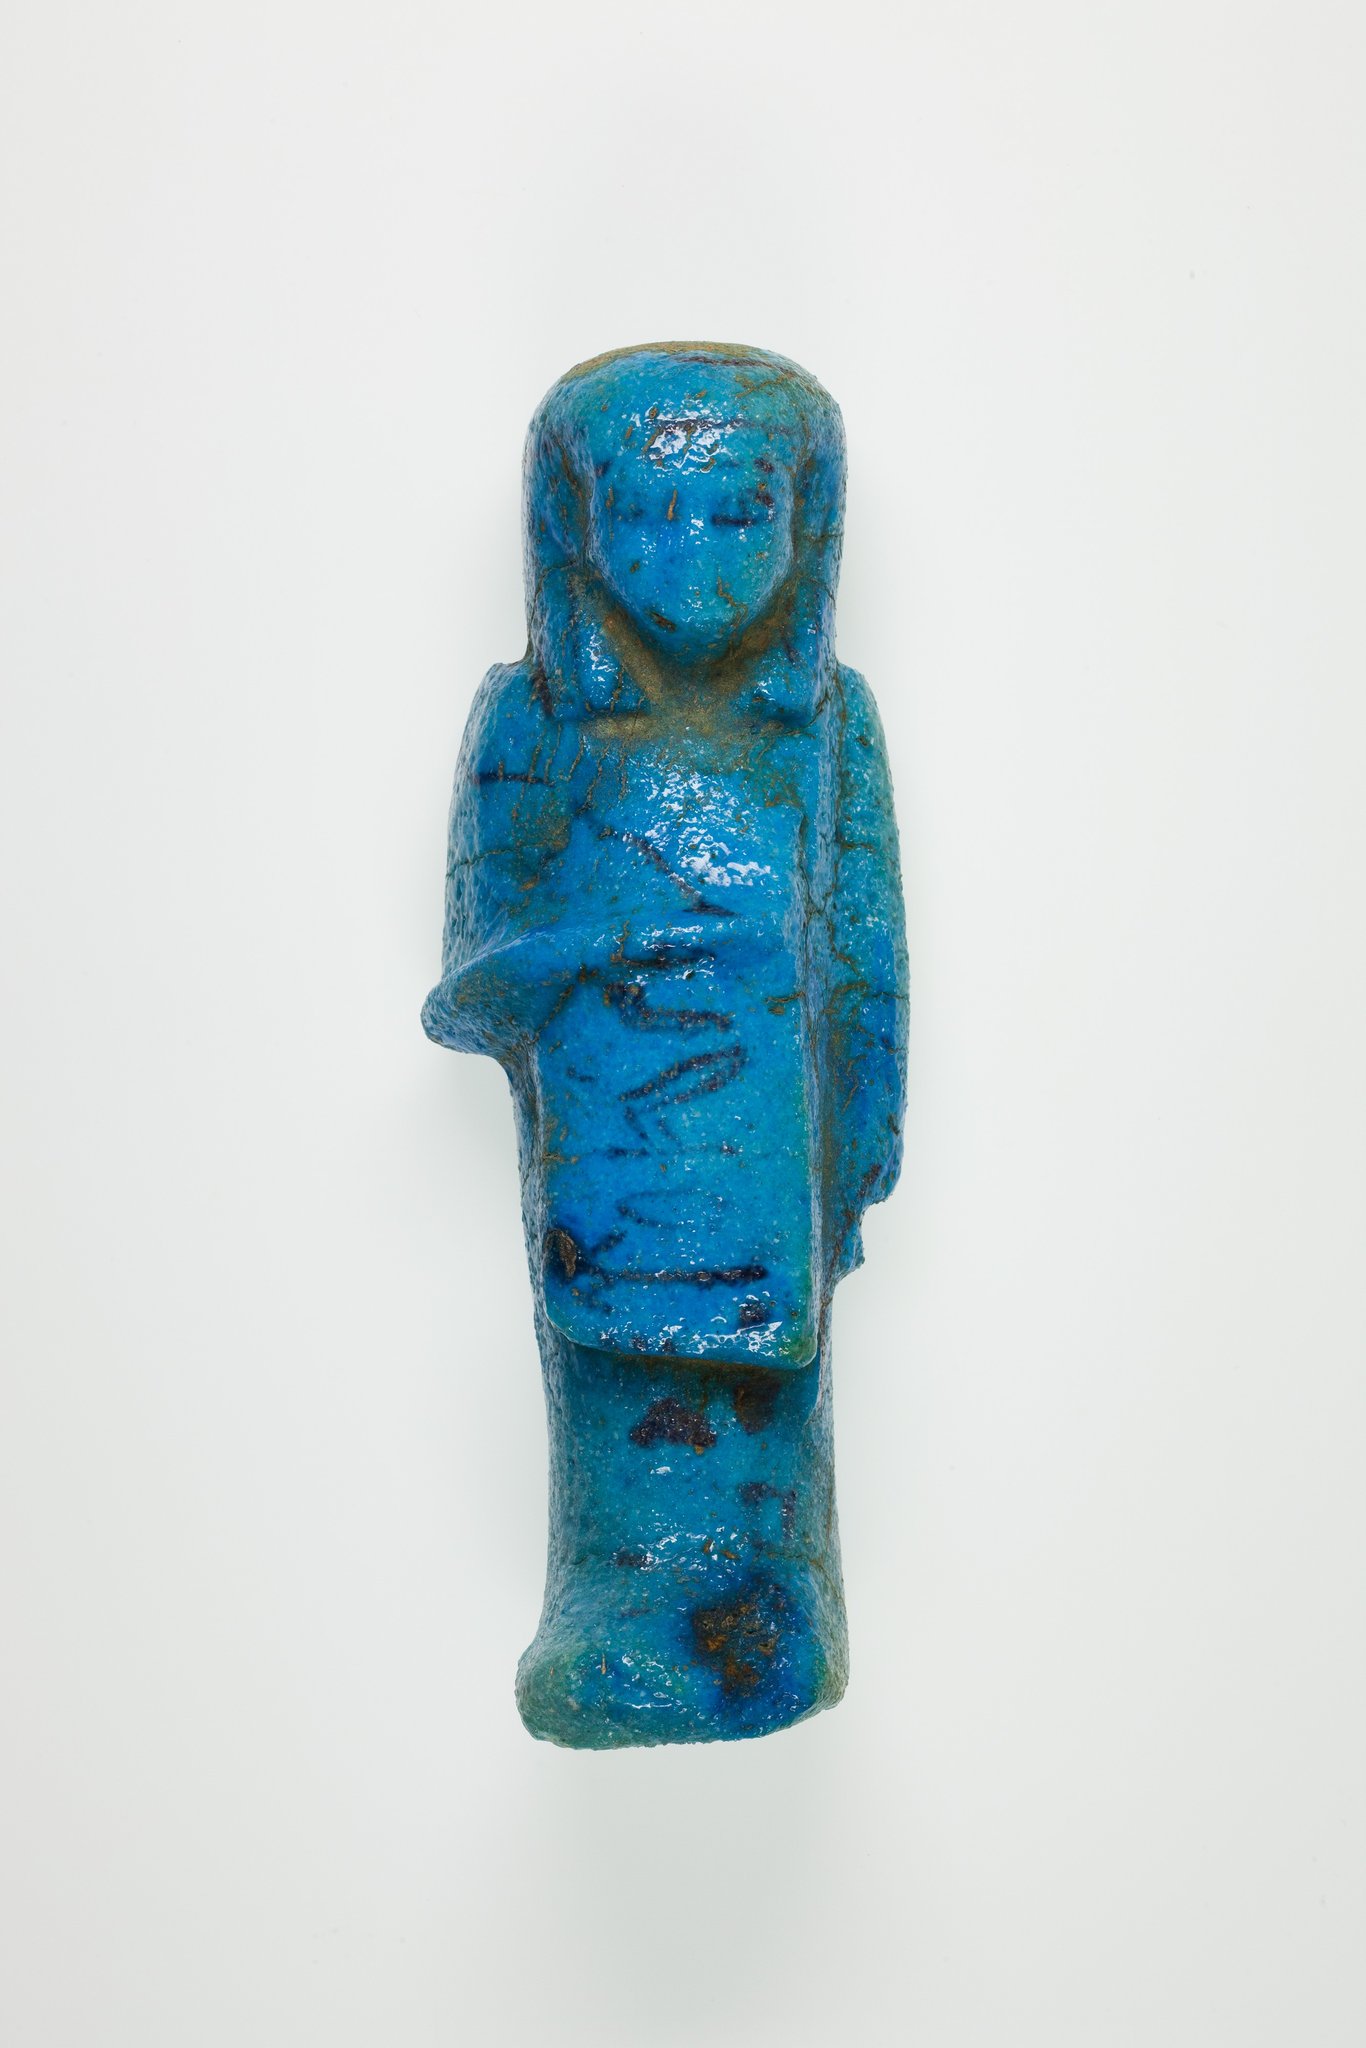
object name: overseer shabti, henettawy c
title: Overseer Shabti of Henettawy (C), Daughter of Isetemkheb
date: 990-970 BCE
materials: faience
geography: egypt